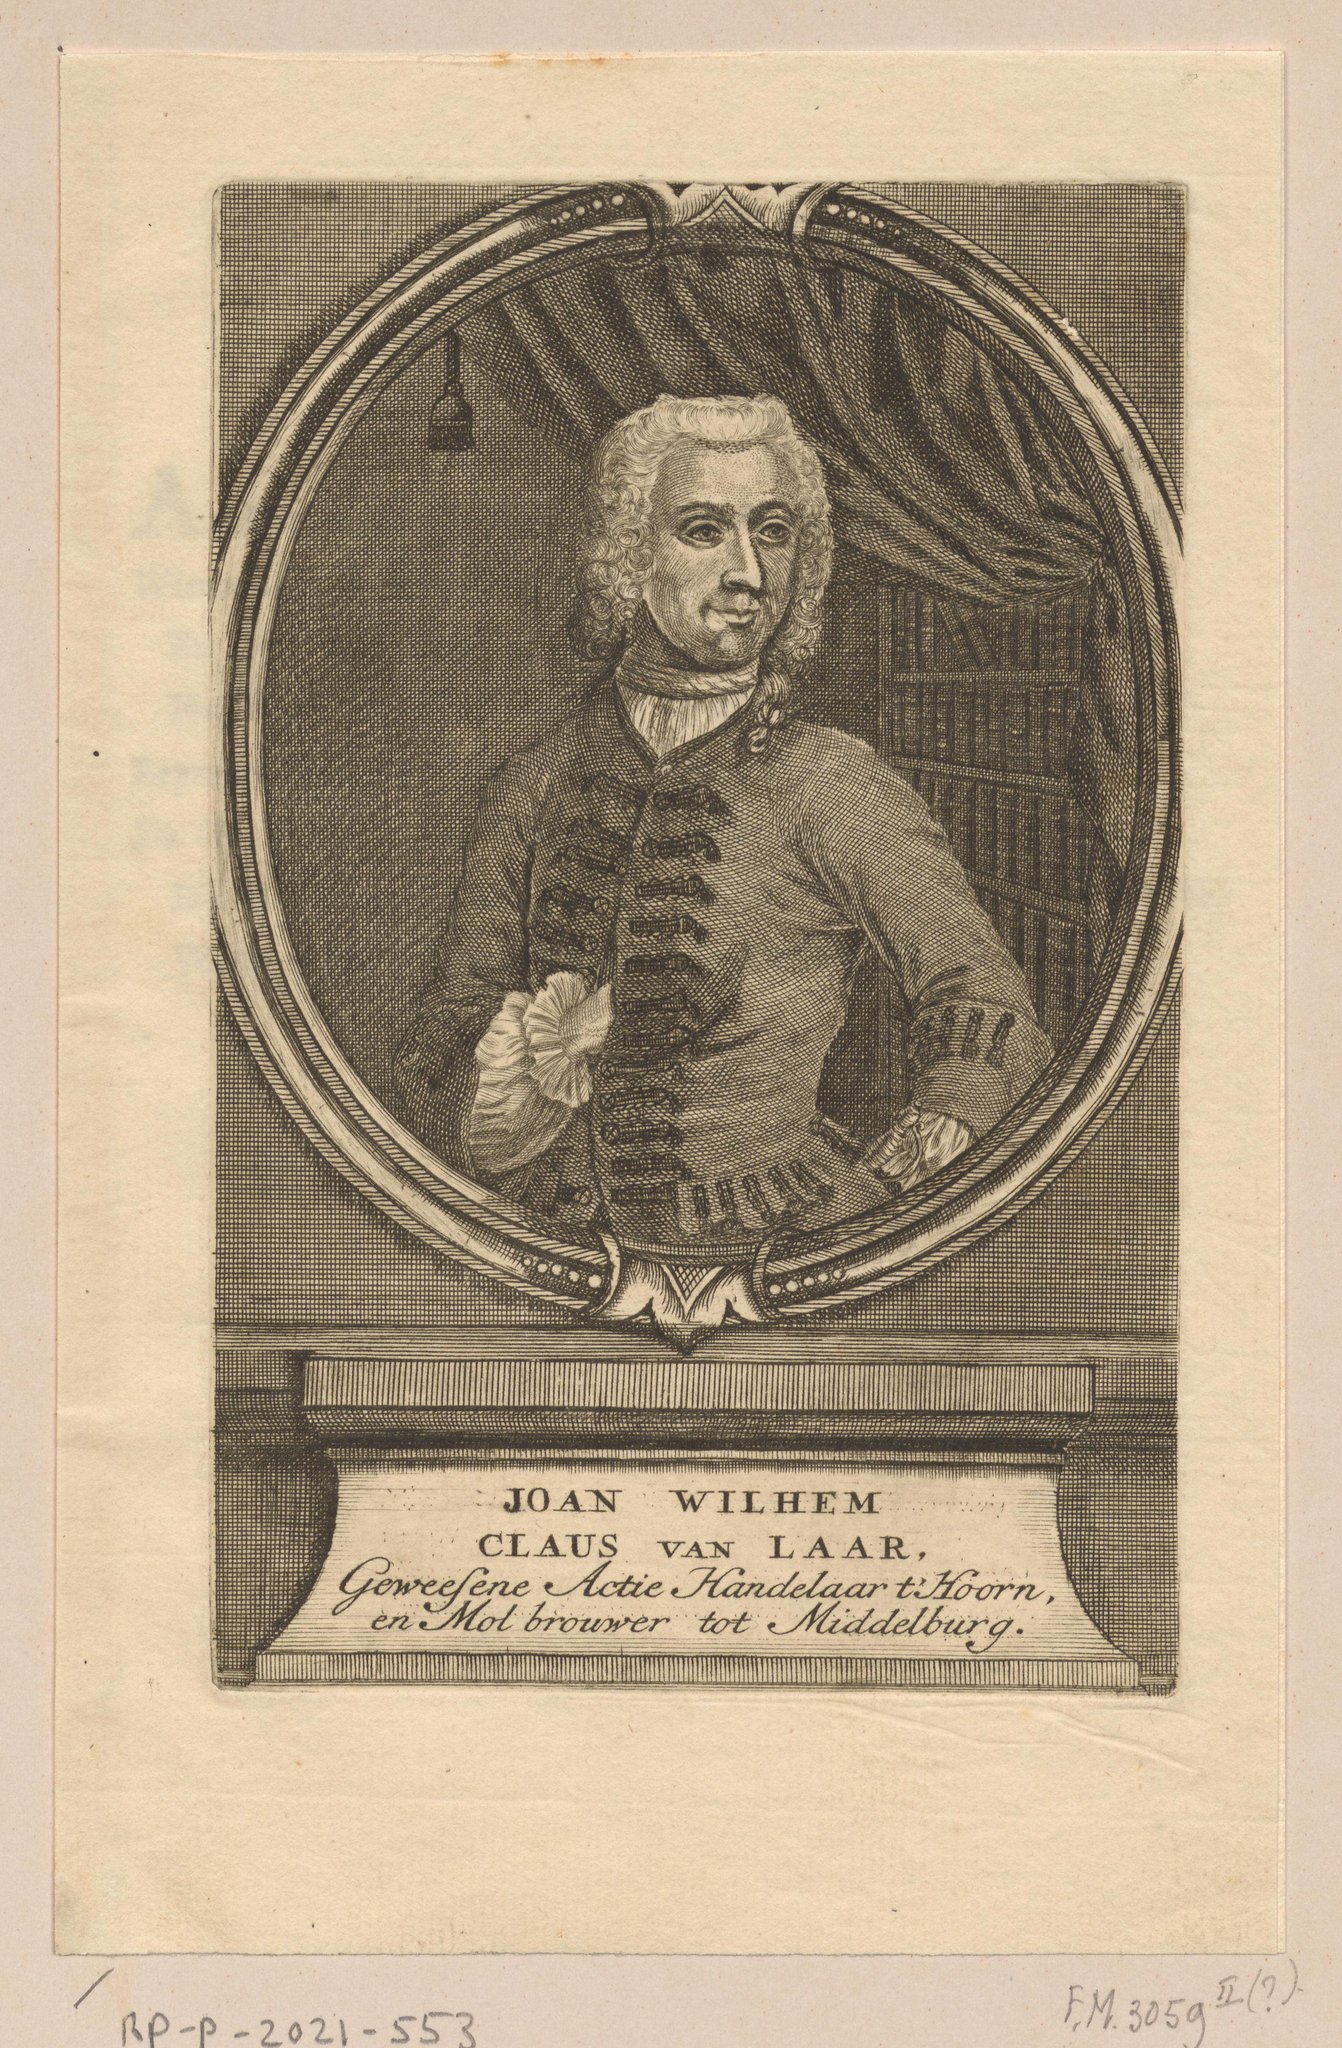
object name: book illustration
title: Portret van Johan Willem Claus van Laar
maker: Anonymous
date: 1745-1746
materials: paper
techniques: engraving, etching, letterpress printing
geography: netherlands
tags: bookshelves, historical persons, portrait of a writer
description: Prent waarschijnlijk uit: De voorlooper van het geestelyke en waereldlyke conclave (...). Middelburg: s.n., [1745], dl. 1. Of uit: Pleitreeden voor Deurhofs Job (...). Harlingen: Folkert van der Plaats, 1746.